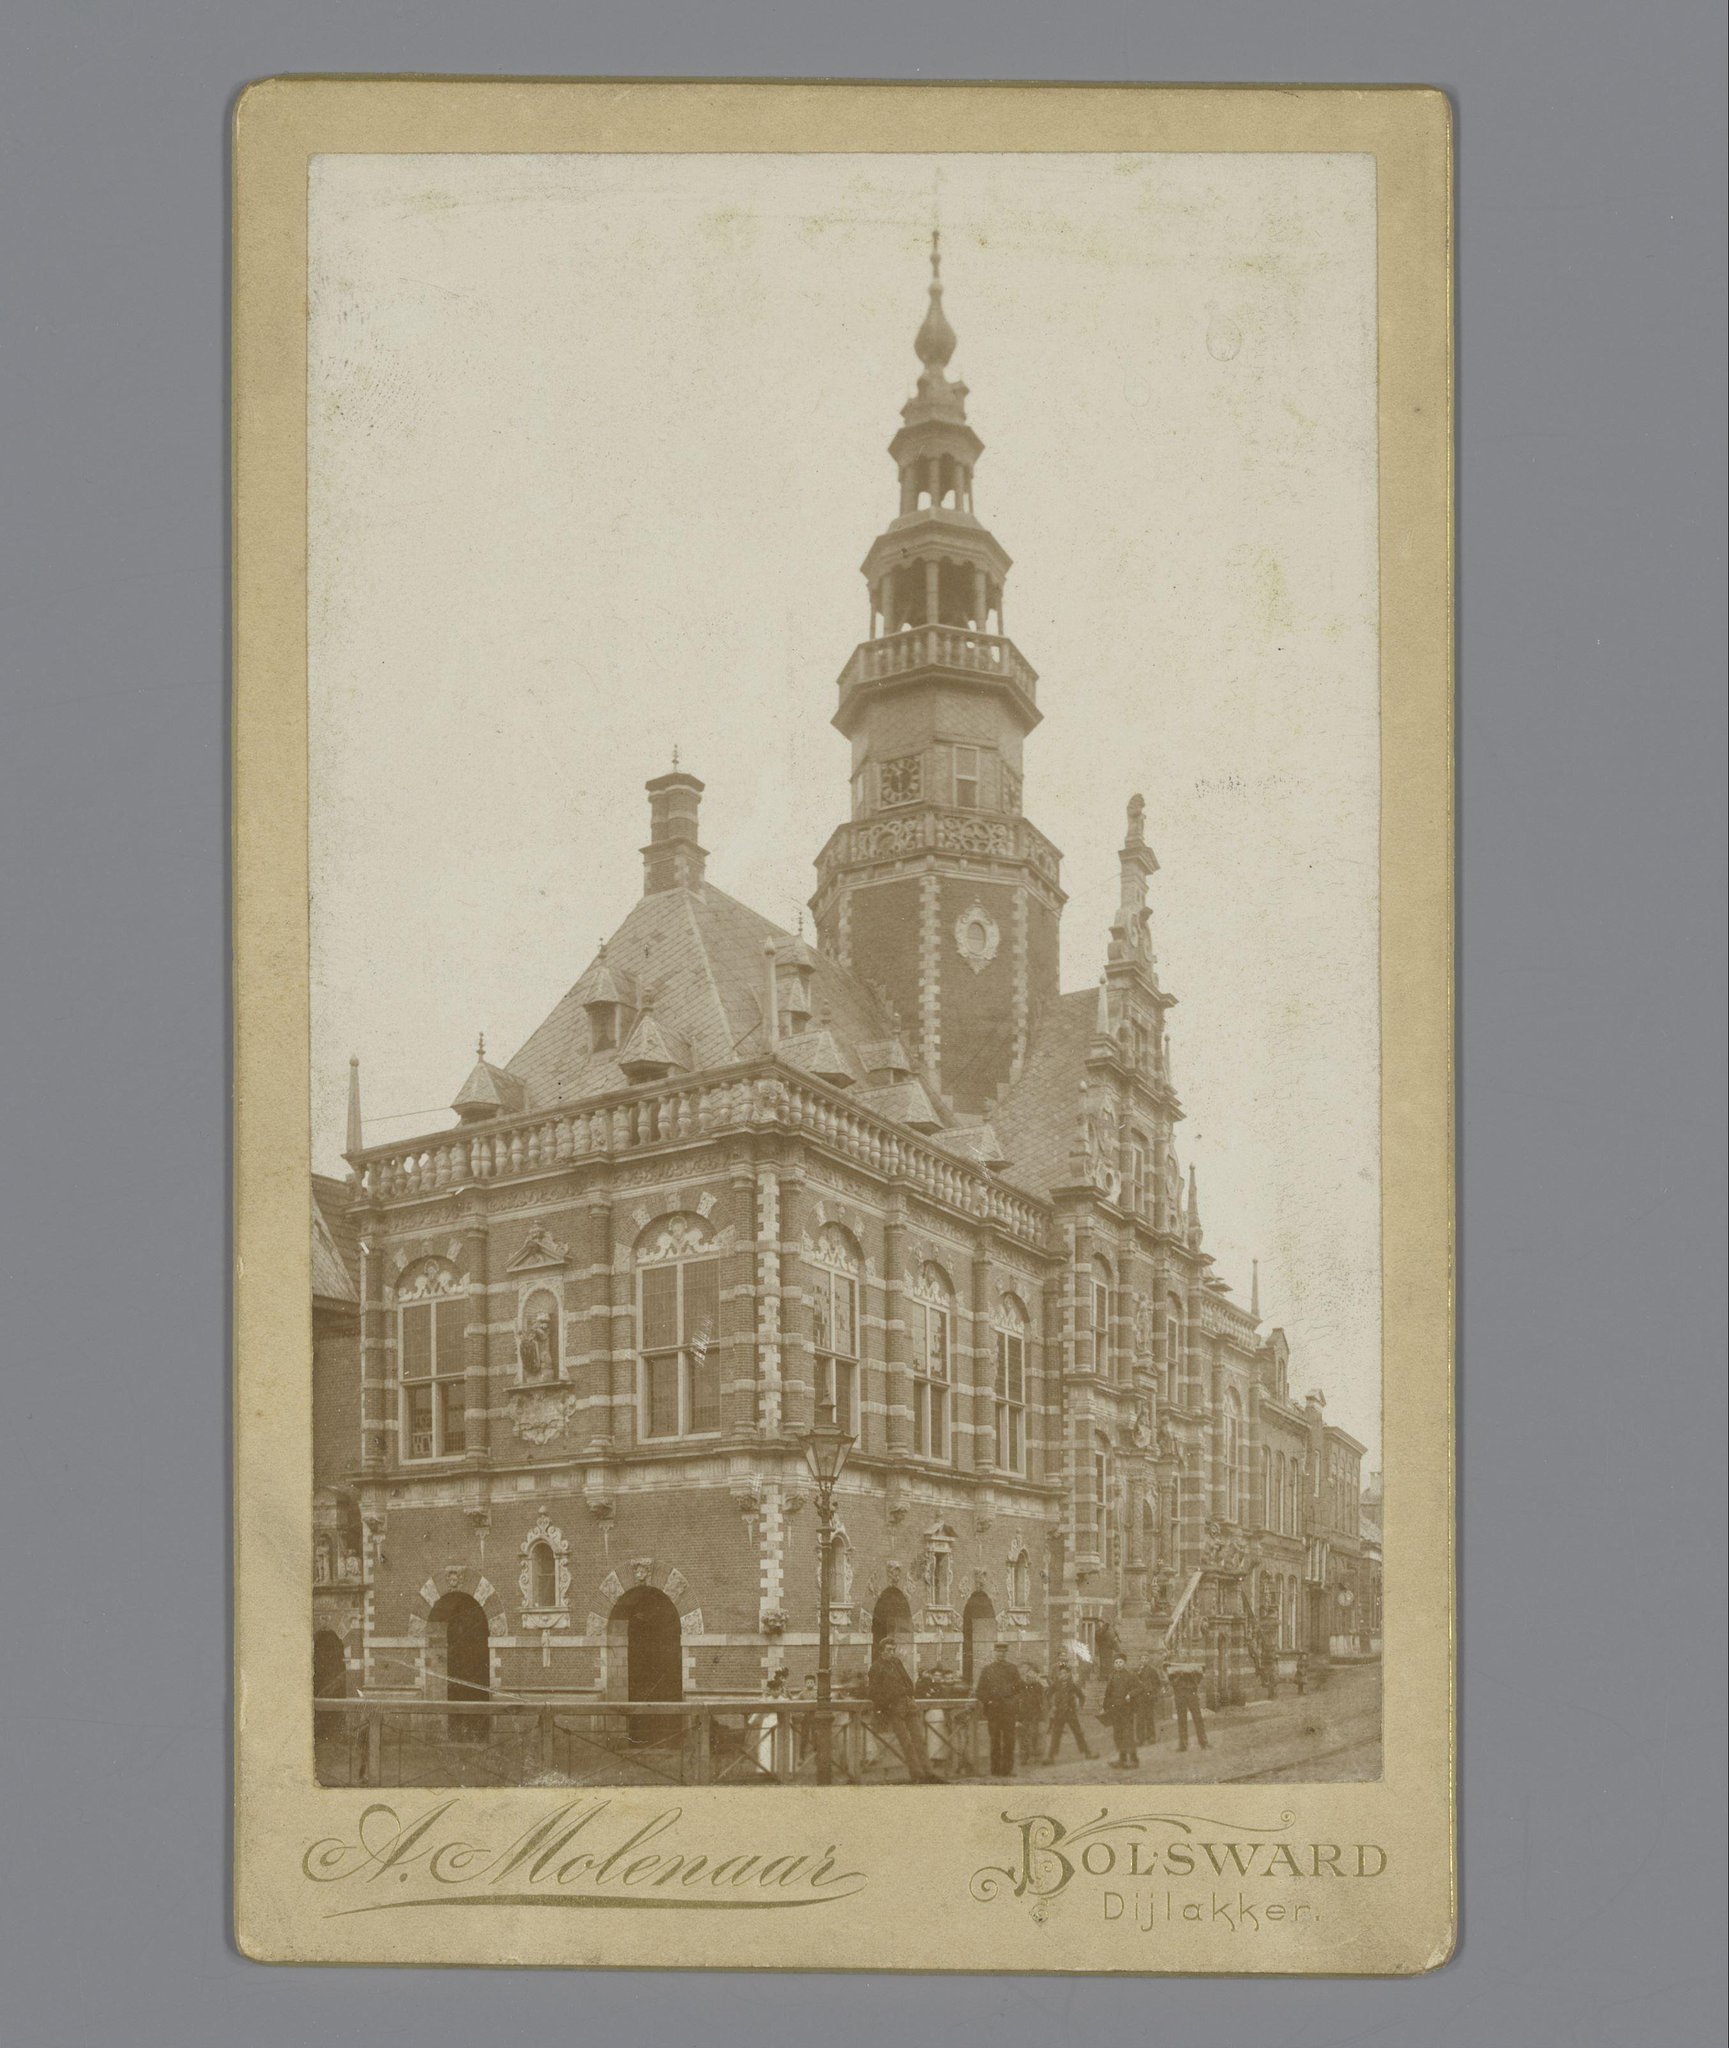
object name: photograph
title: Stadhuis te Bolsward, Friesland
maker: anne molenaar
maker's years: 1868-1945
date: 1885-1905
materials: cardboard, photographic support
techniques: collodion silver print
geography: bolsward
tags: townhall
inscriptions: annotation: ‘108/ top’, inscription: ‘A. Molenaar / Bolsward / Dijlakker.’, retailer's mark: ‘K. FALKENA BZN / BOEK EN KANTOORHANDEL / BOLSWARD / TEGEN OVER 'T STADHUIS’